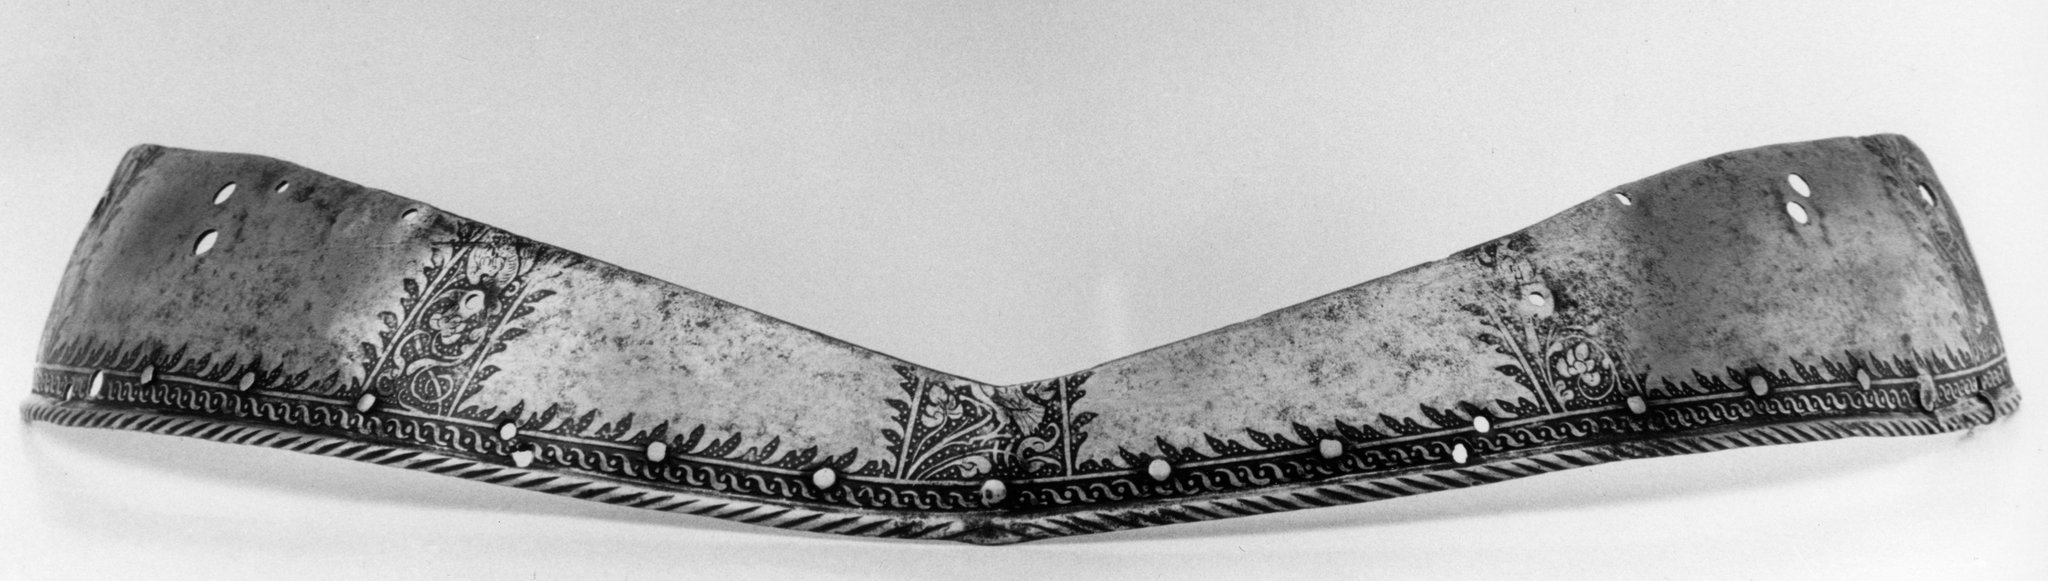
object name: waist lame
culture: german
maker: wolfgang grosschedel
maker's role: armorer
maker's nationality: german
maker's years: 1517-1562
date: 1555-1560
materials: steel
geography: germany